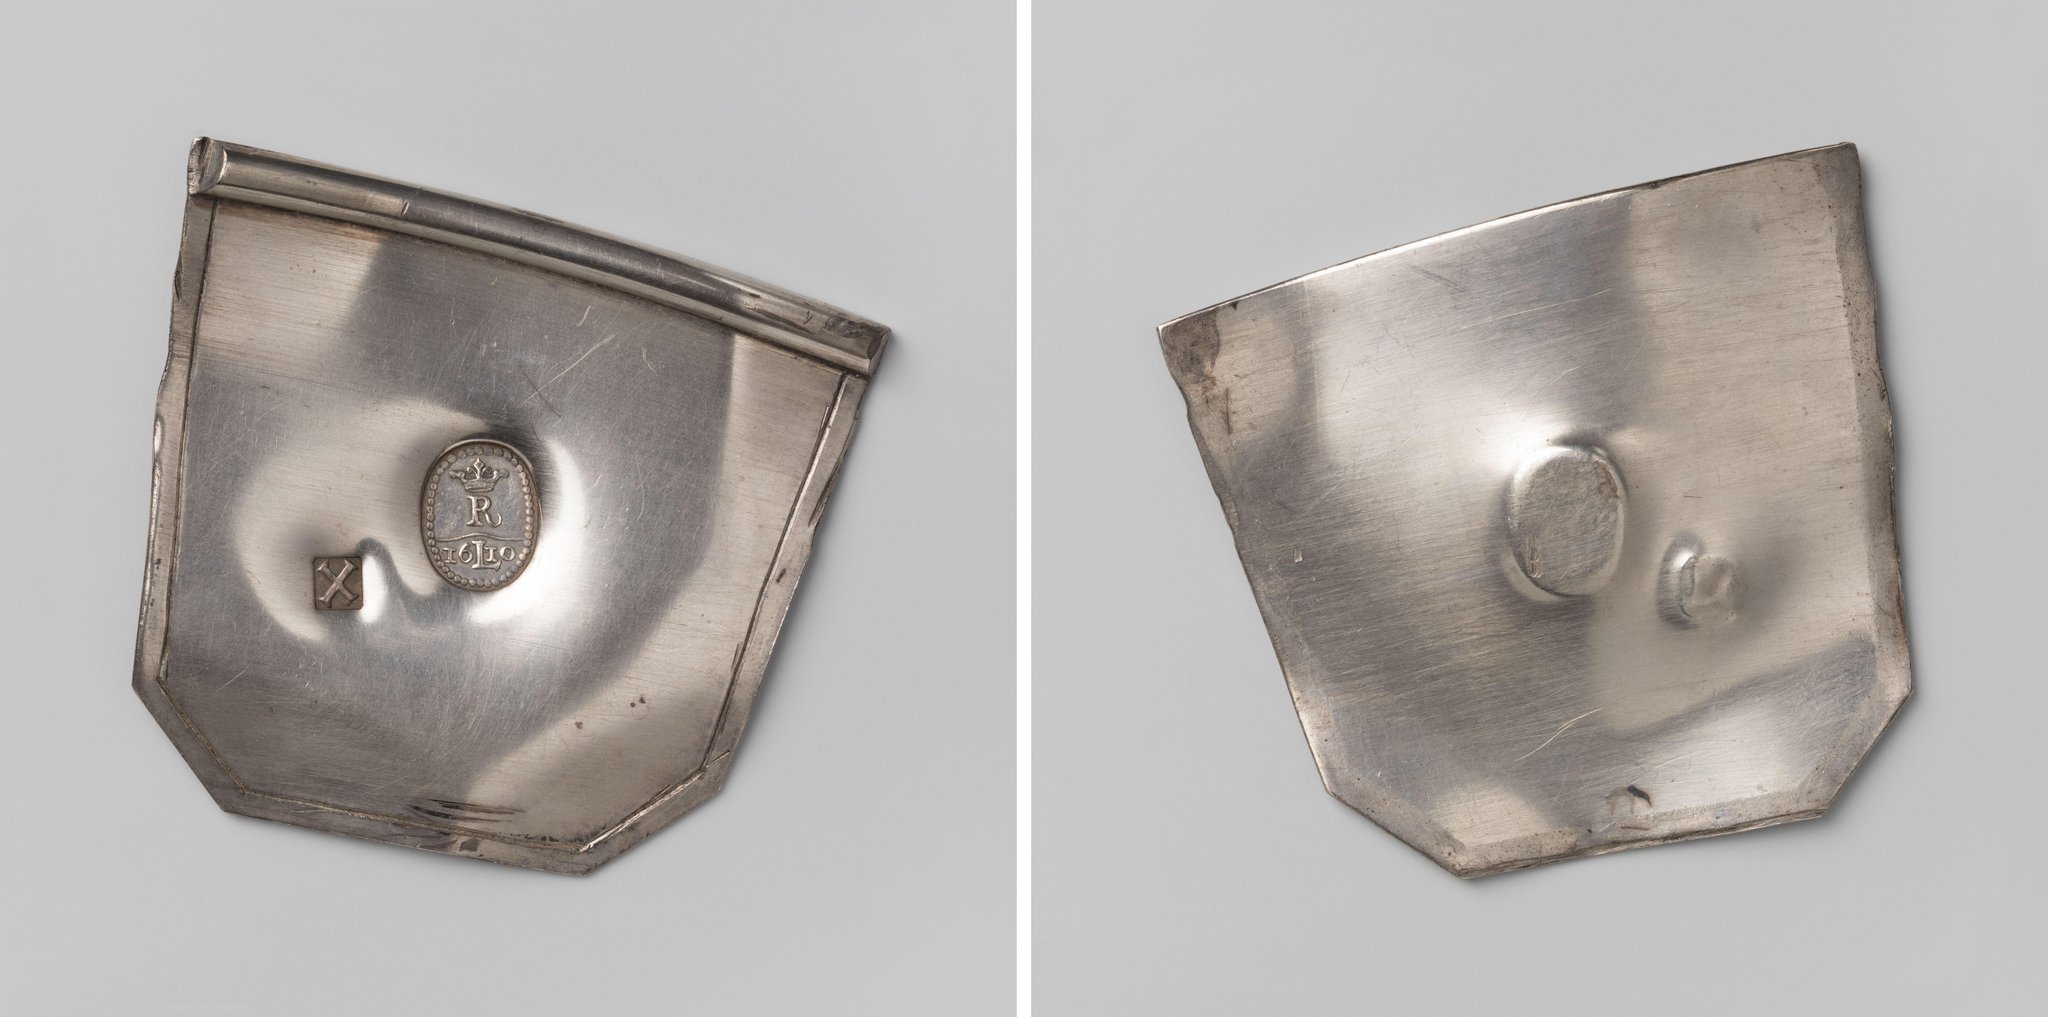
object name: tien eenheden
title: Tien eenheden, noodmunt uit Gulik, geslagen tijdens het beleg door Maurits, prins van Oranje-Nassau, vervaardigd door stuk te knippen uit bord of kom en bestempeld met het monogram van Rudolf II, Duits keizer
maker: Anonymous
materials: silver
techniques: striking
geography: gulik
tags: the hague, maurice (prince of orange), vienna, prague, rudolf ii van habsburg (duits keizer)